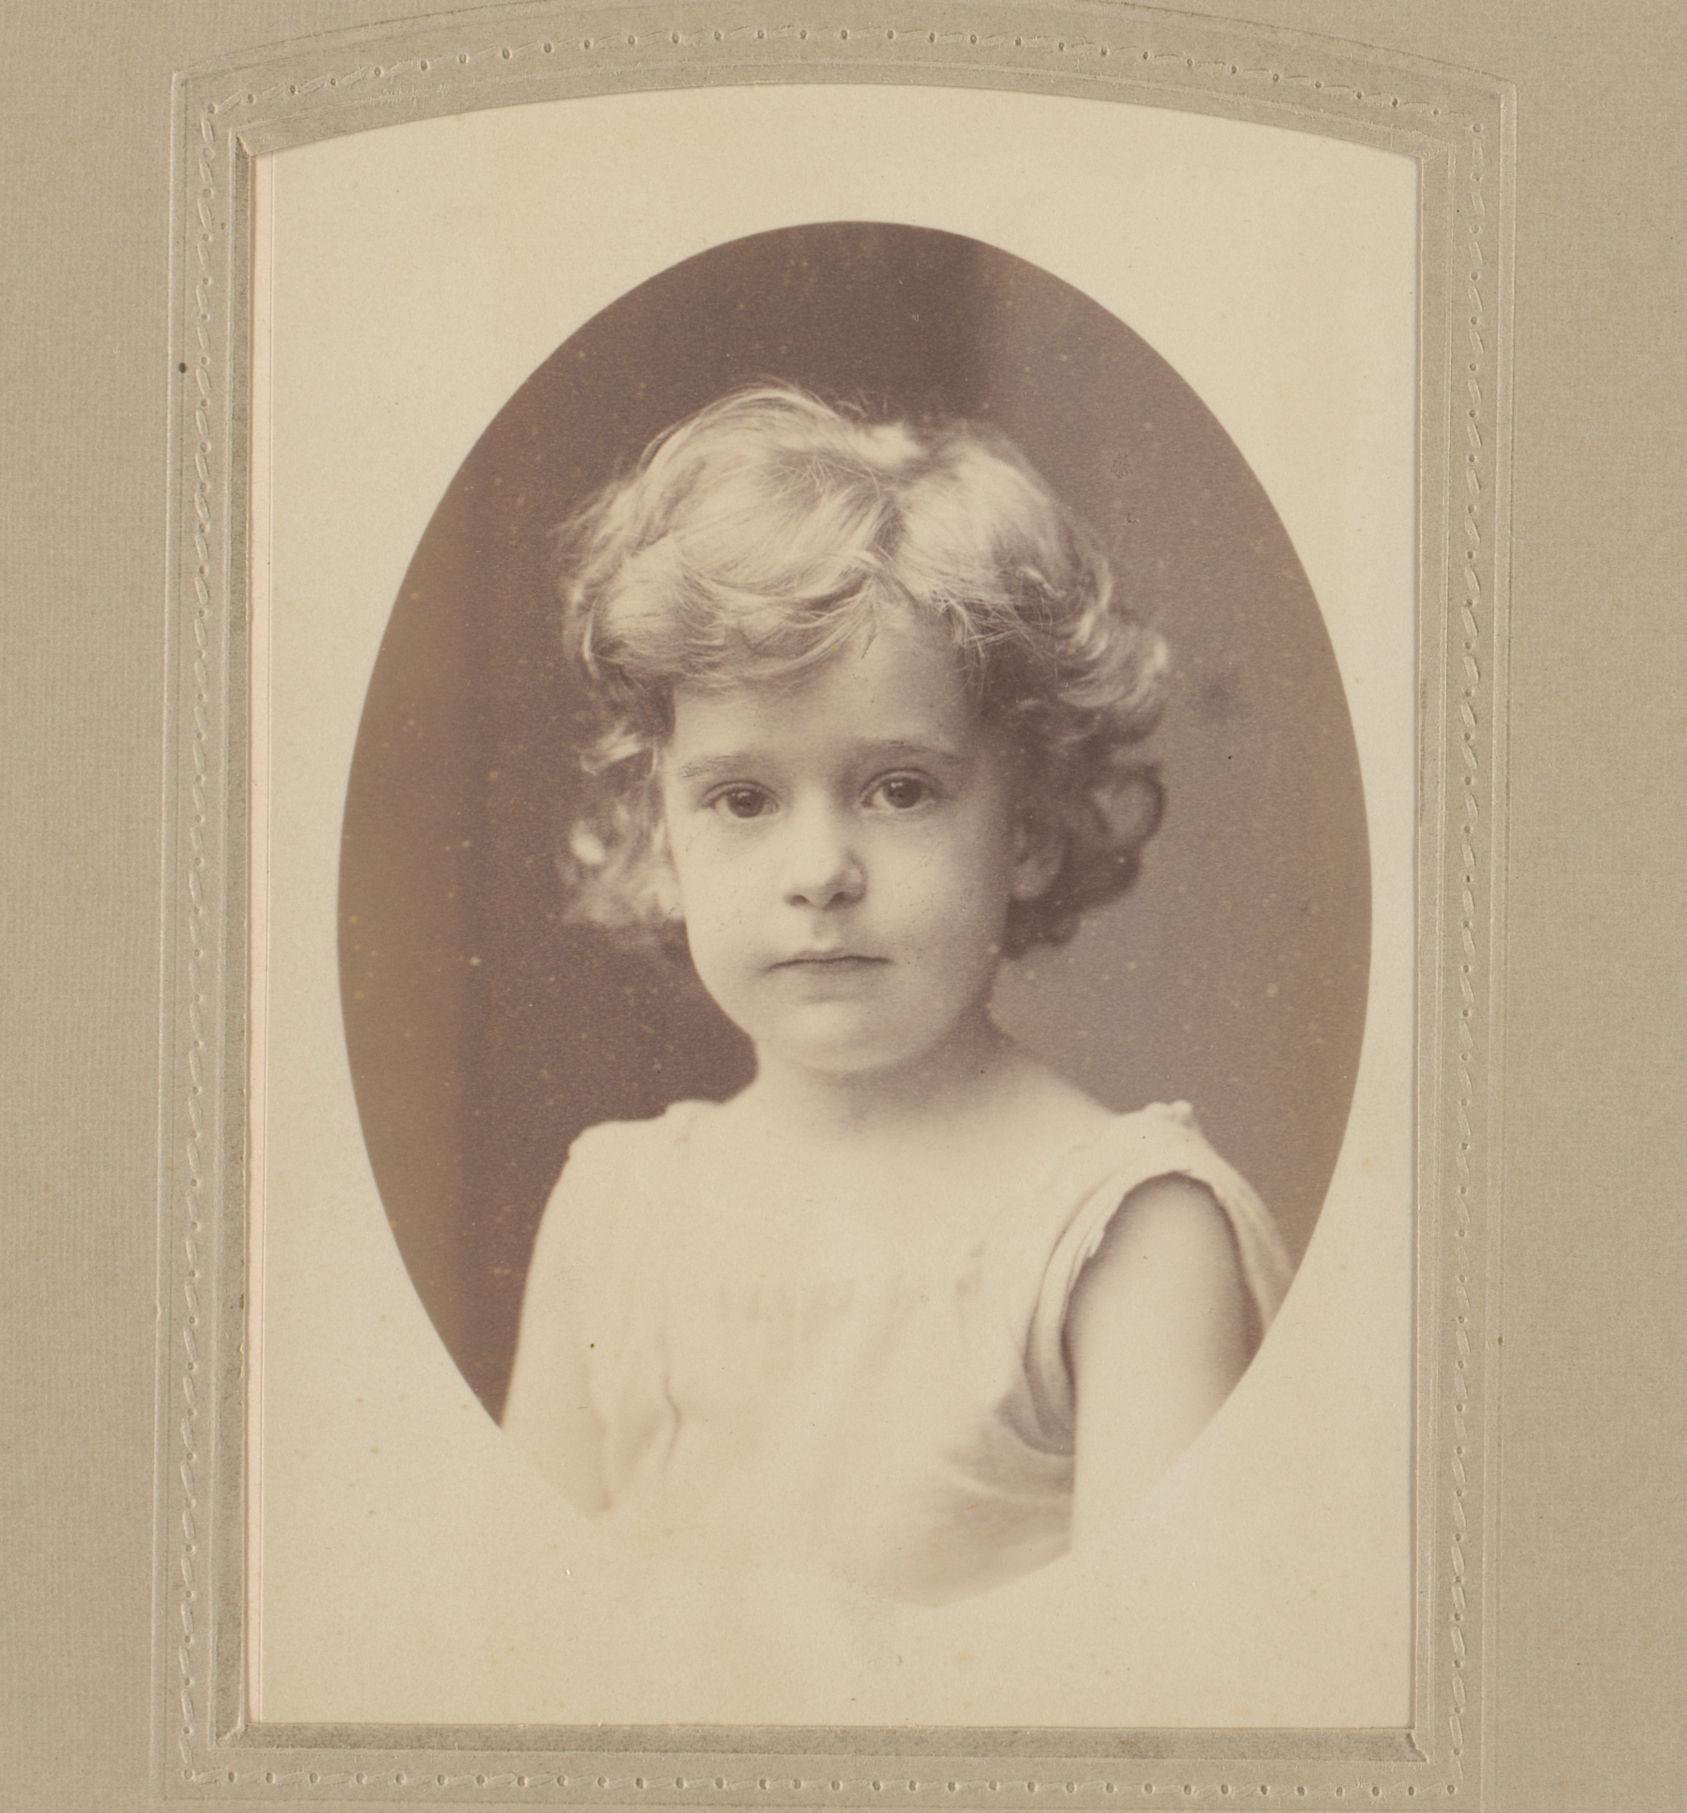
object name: cabinet photograph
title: Portret van Herman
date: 1901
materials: paper, photographic support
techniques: albumen print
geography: netherlands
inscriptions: title: ‘Herman 8 okt 1901’